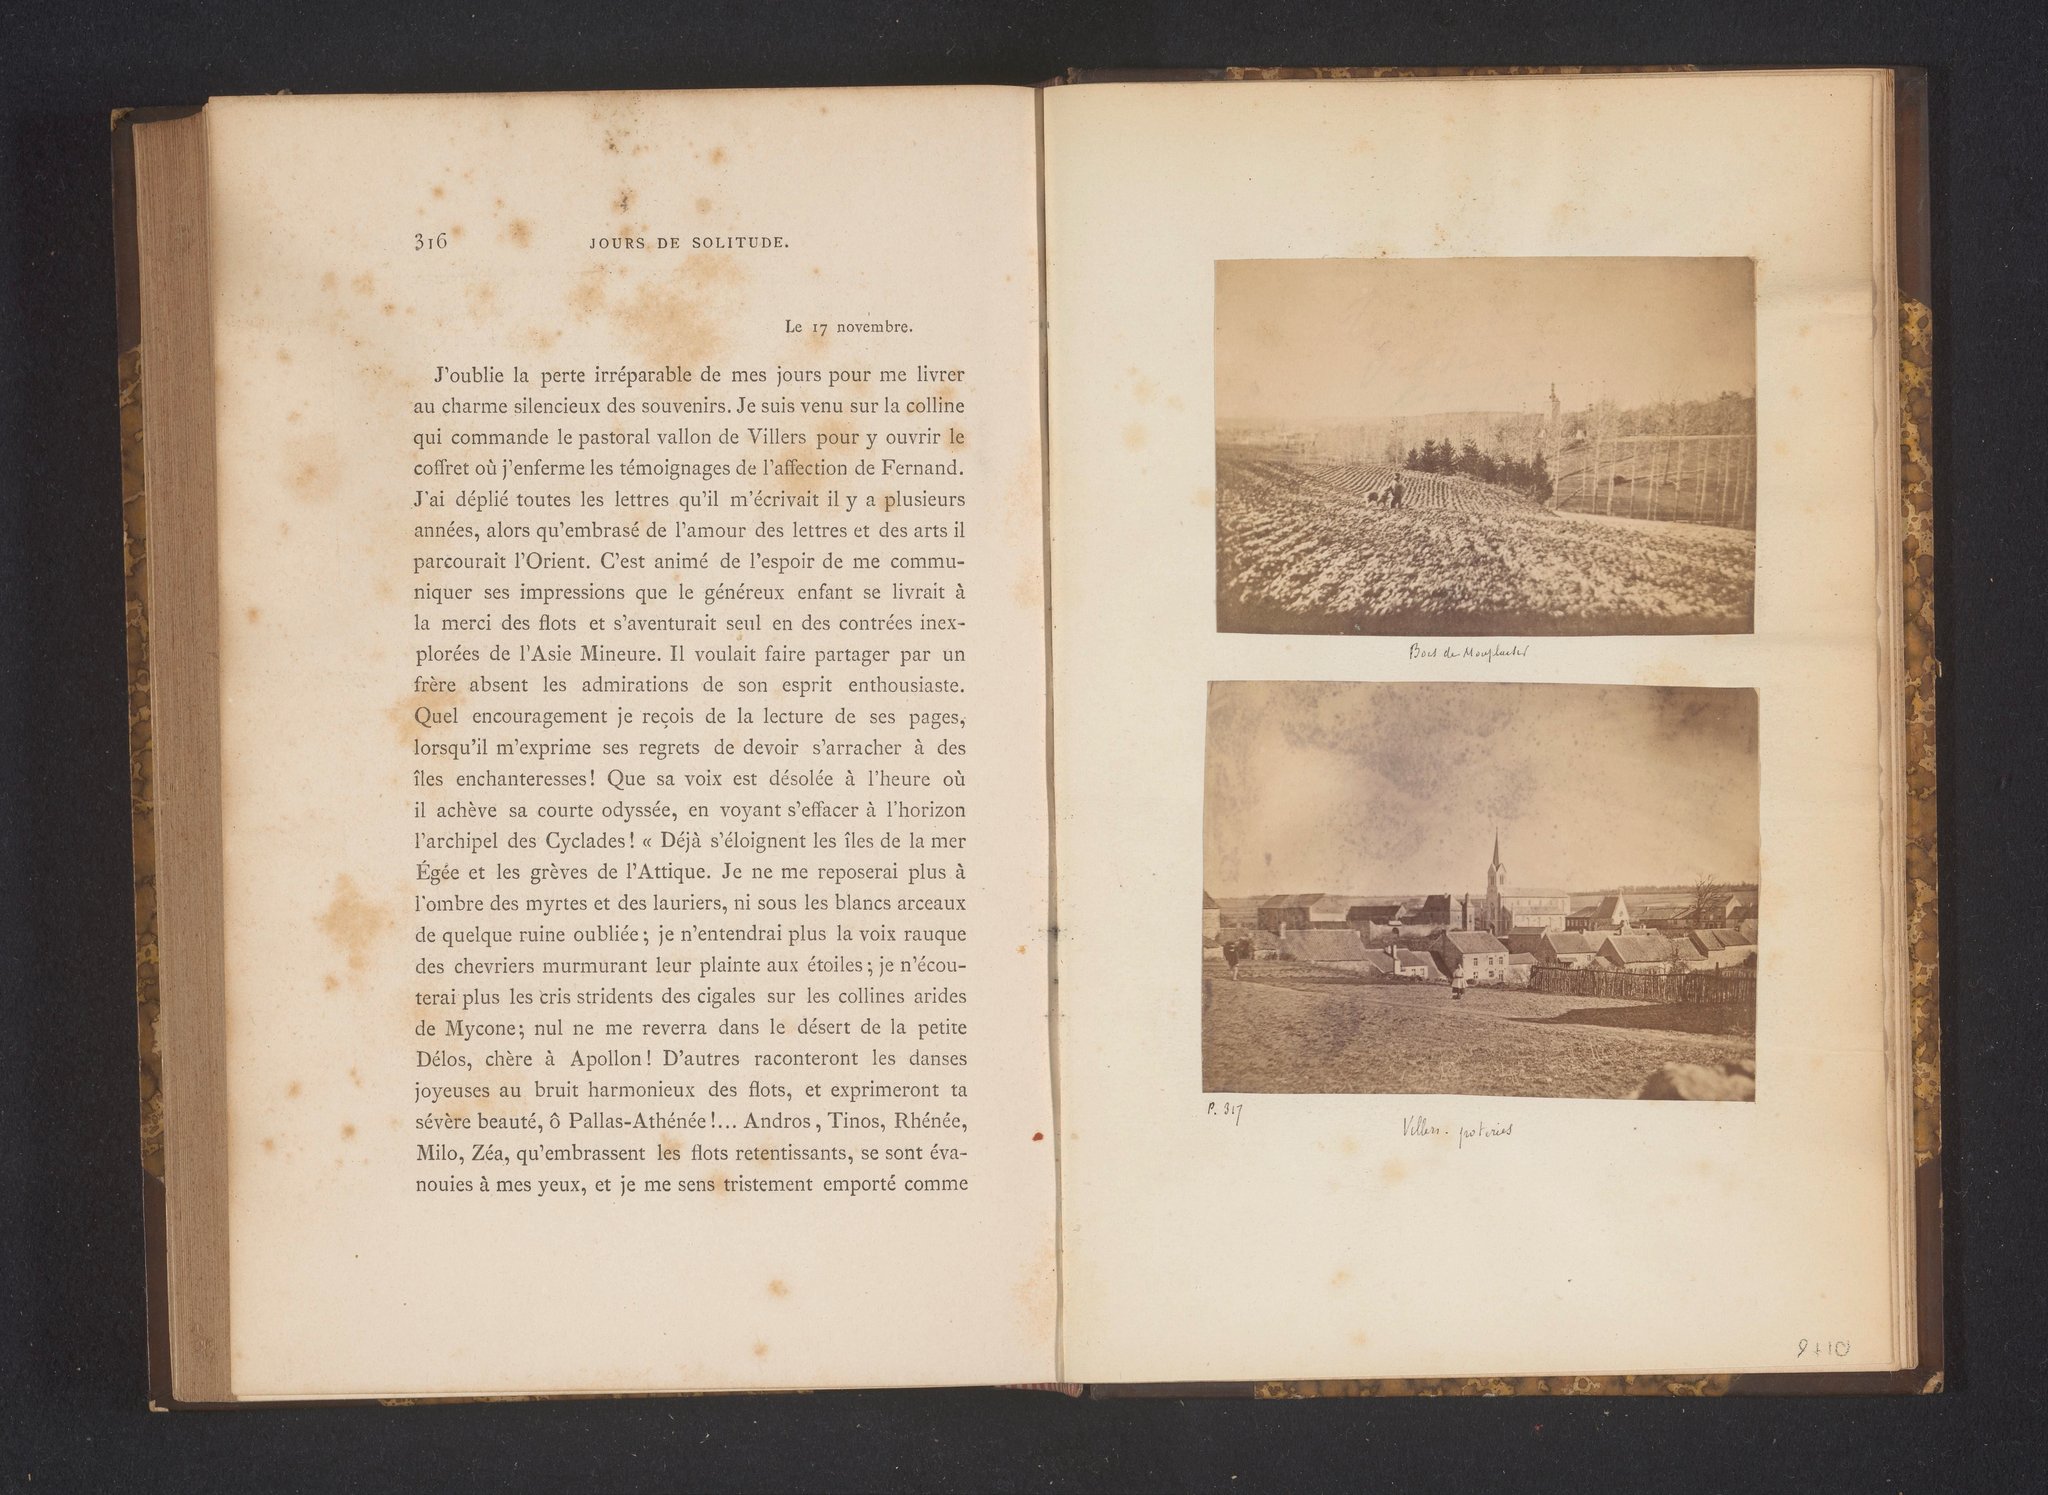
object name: page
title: Gezicht op een onbekend persoon op een akker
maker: Anonymous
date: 1872-1877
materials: photographic support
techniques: albumen print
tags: historical persons, cultivated land, belgium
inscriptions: inscription: ‘Bois de [...]’